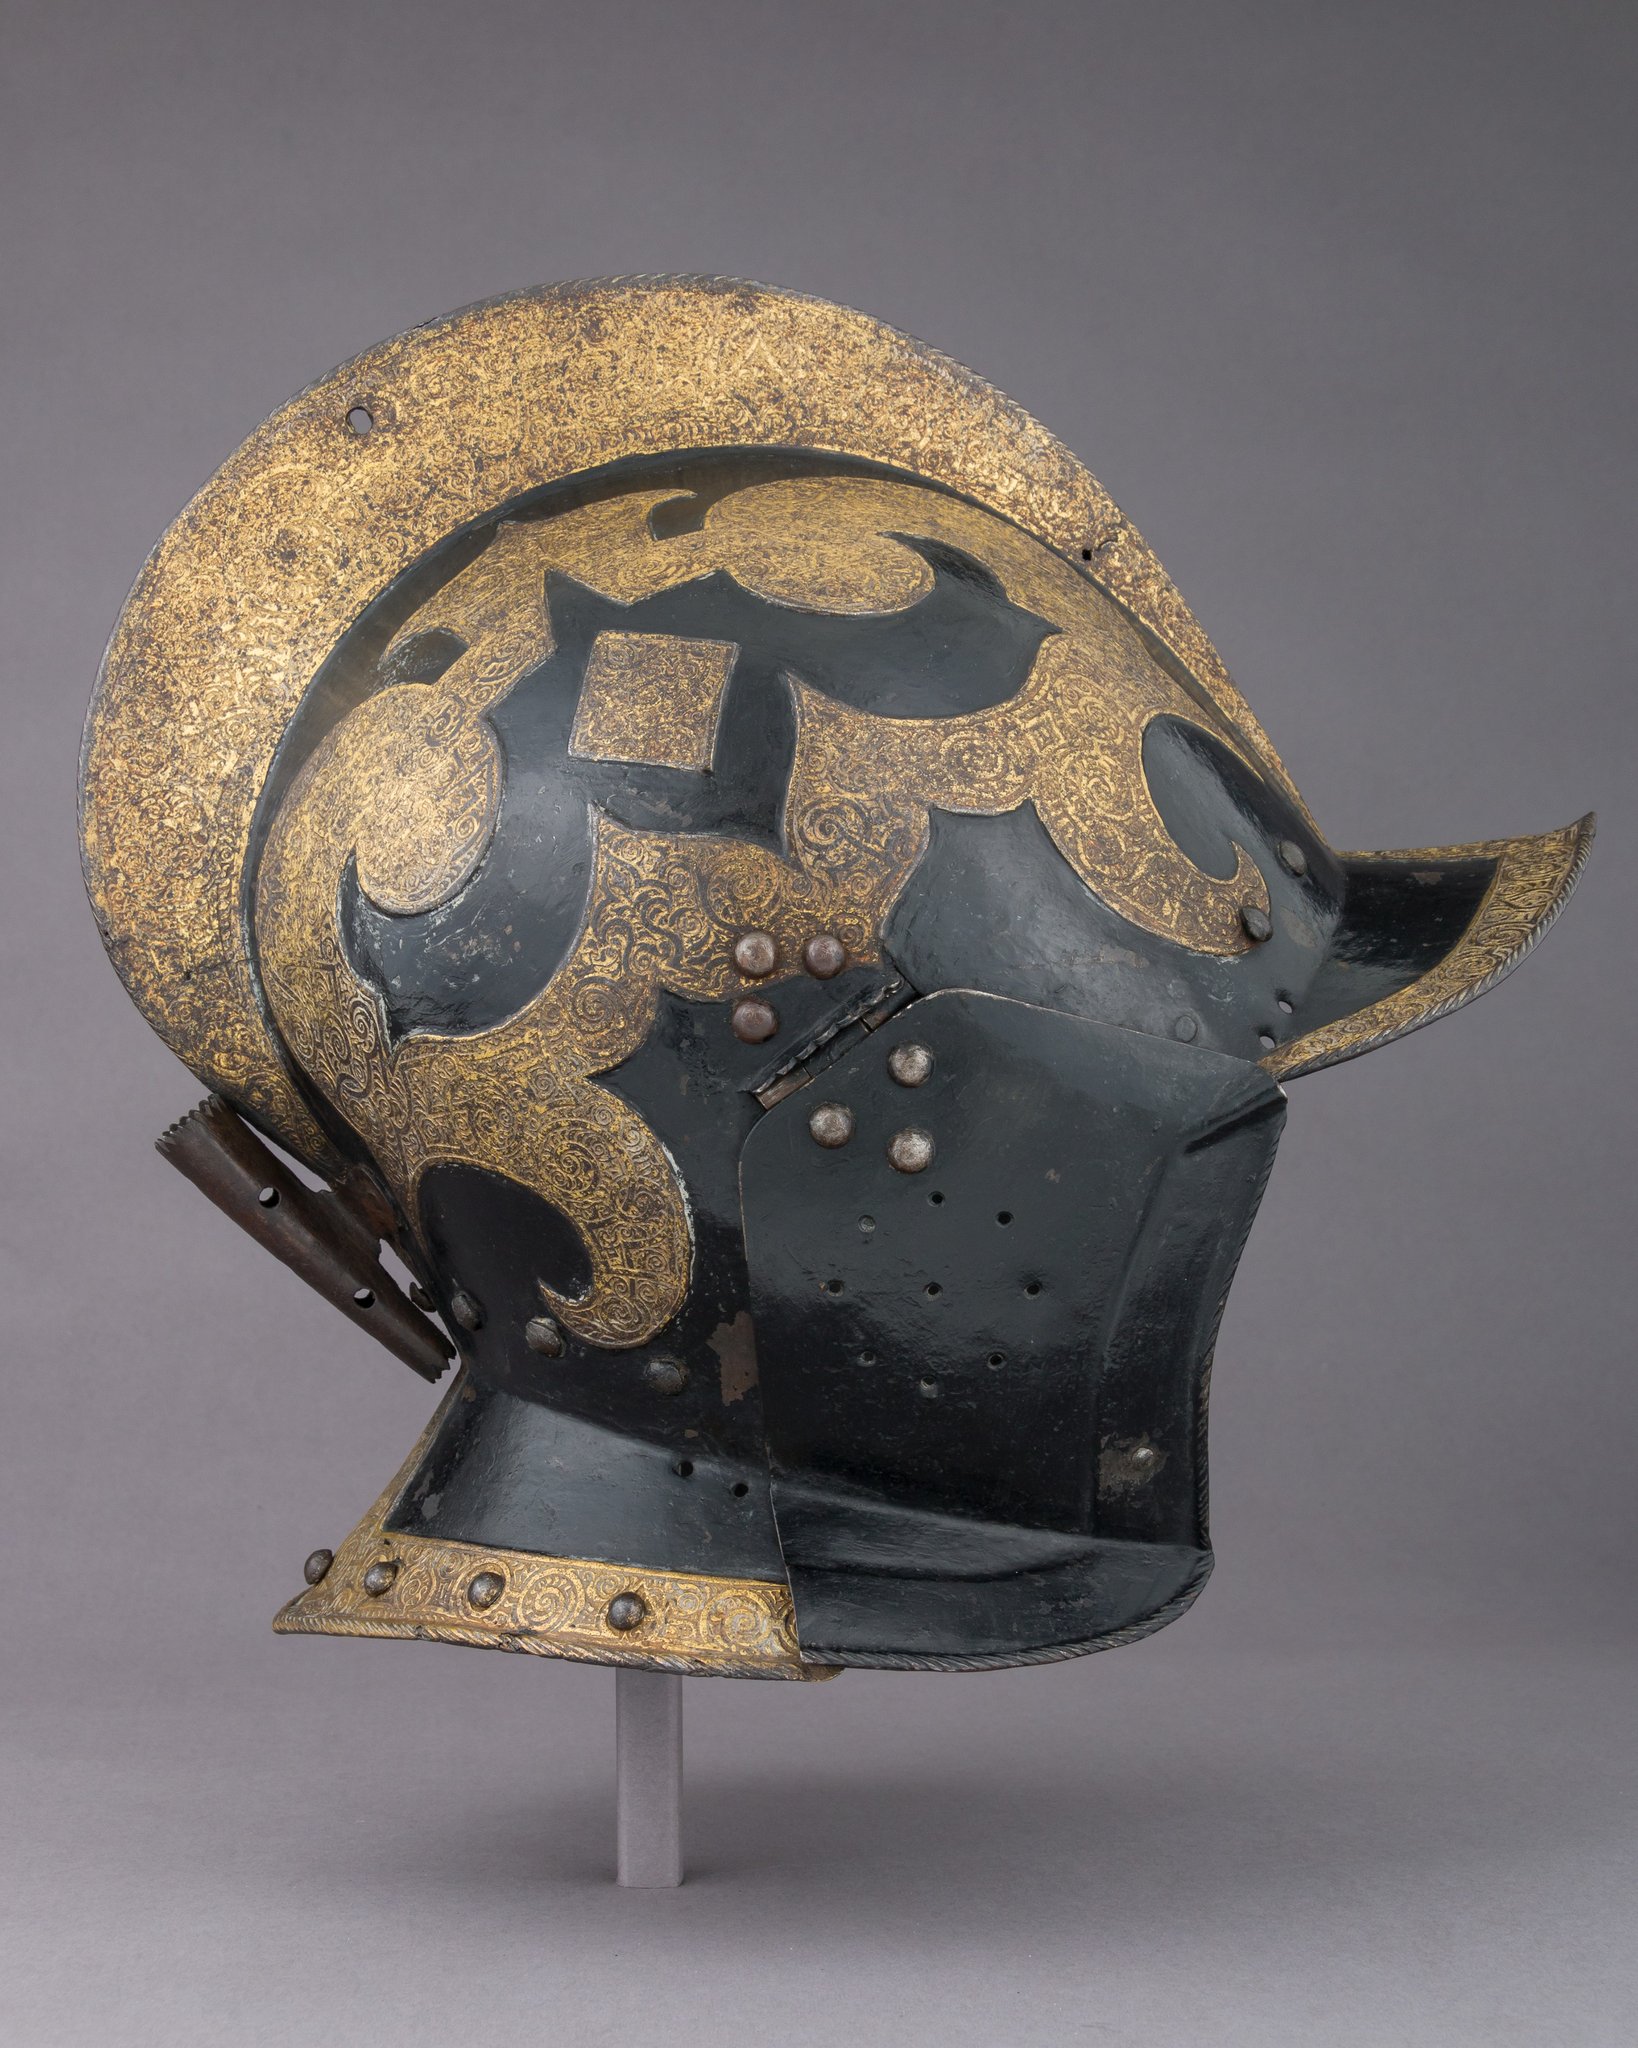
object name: burgonet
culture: german, saxon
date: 1501-1600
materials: gold, leather, pigment, steel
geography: germany